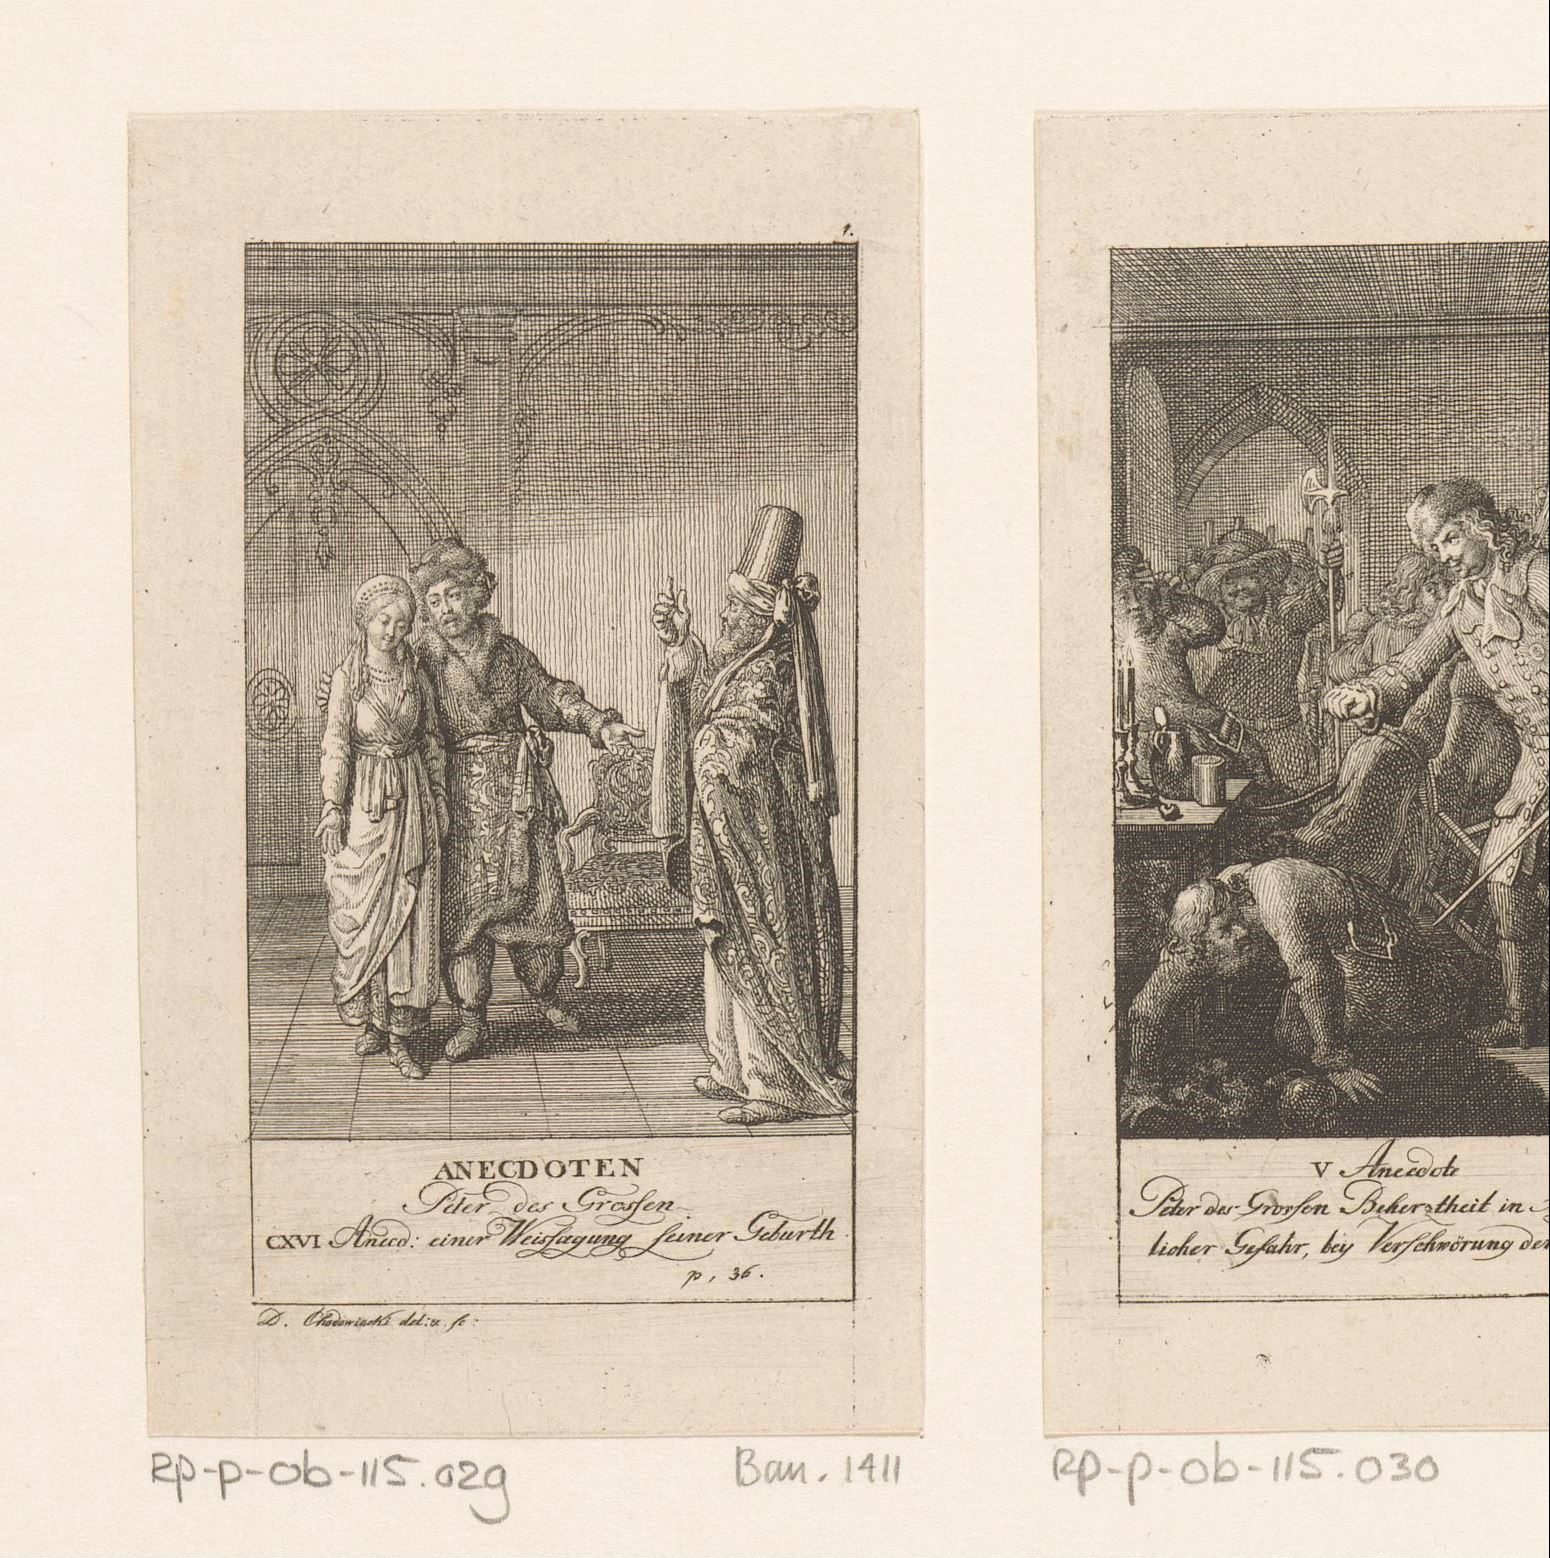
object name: print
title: Peter de Grote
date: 1789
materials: paper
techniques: etching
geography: berlin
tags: peter i de grote (tsaar van rusland), literature, emperor, couple of lovers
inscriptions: collector's mark: Lugt 2228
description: Vervaardigd voor 'Anekdoten vom Peter dem Grossen'. Prent gebruikt voor: Goettinger Taschen Calender vom Jahr 1790. Göttingen: Johann Christoph Dietrich, [1789].